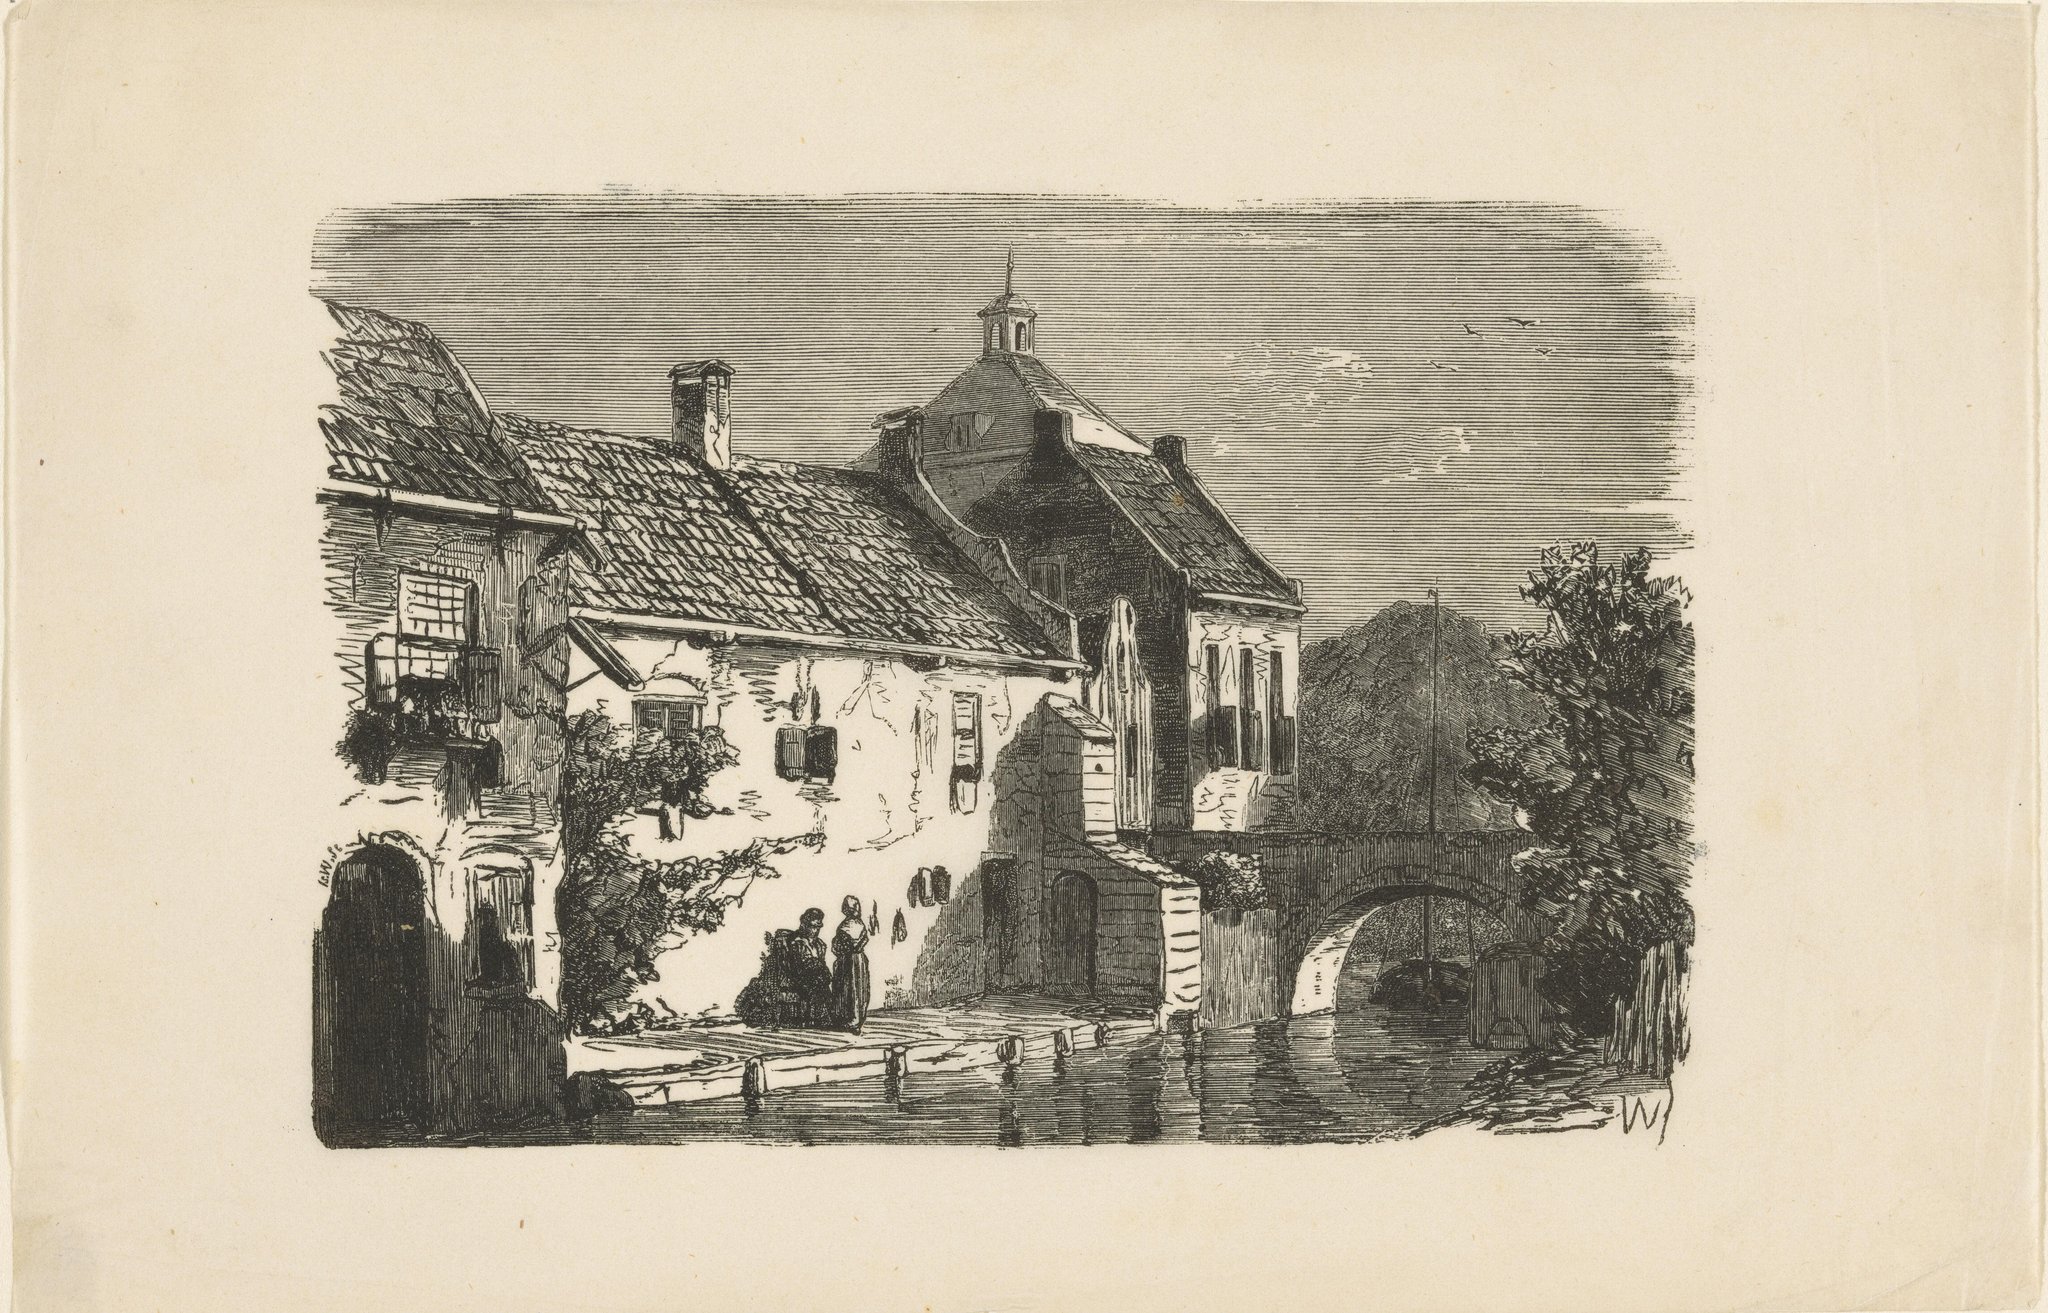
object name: print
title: Stadsgezicht te IJsselstein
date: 1836-1912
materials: paper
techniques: engraving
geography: netherlands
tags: bridge in city across river, canal, etc. (+ city(-scape) with figures, staffage)